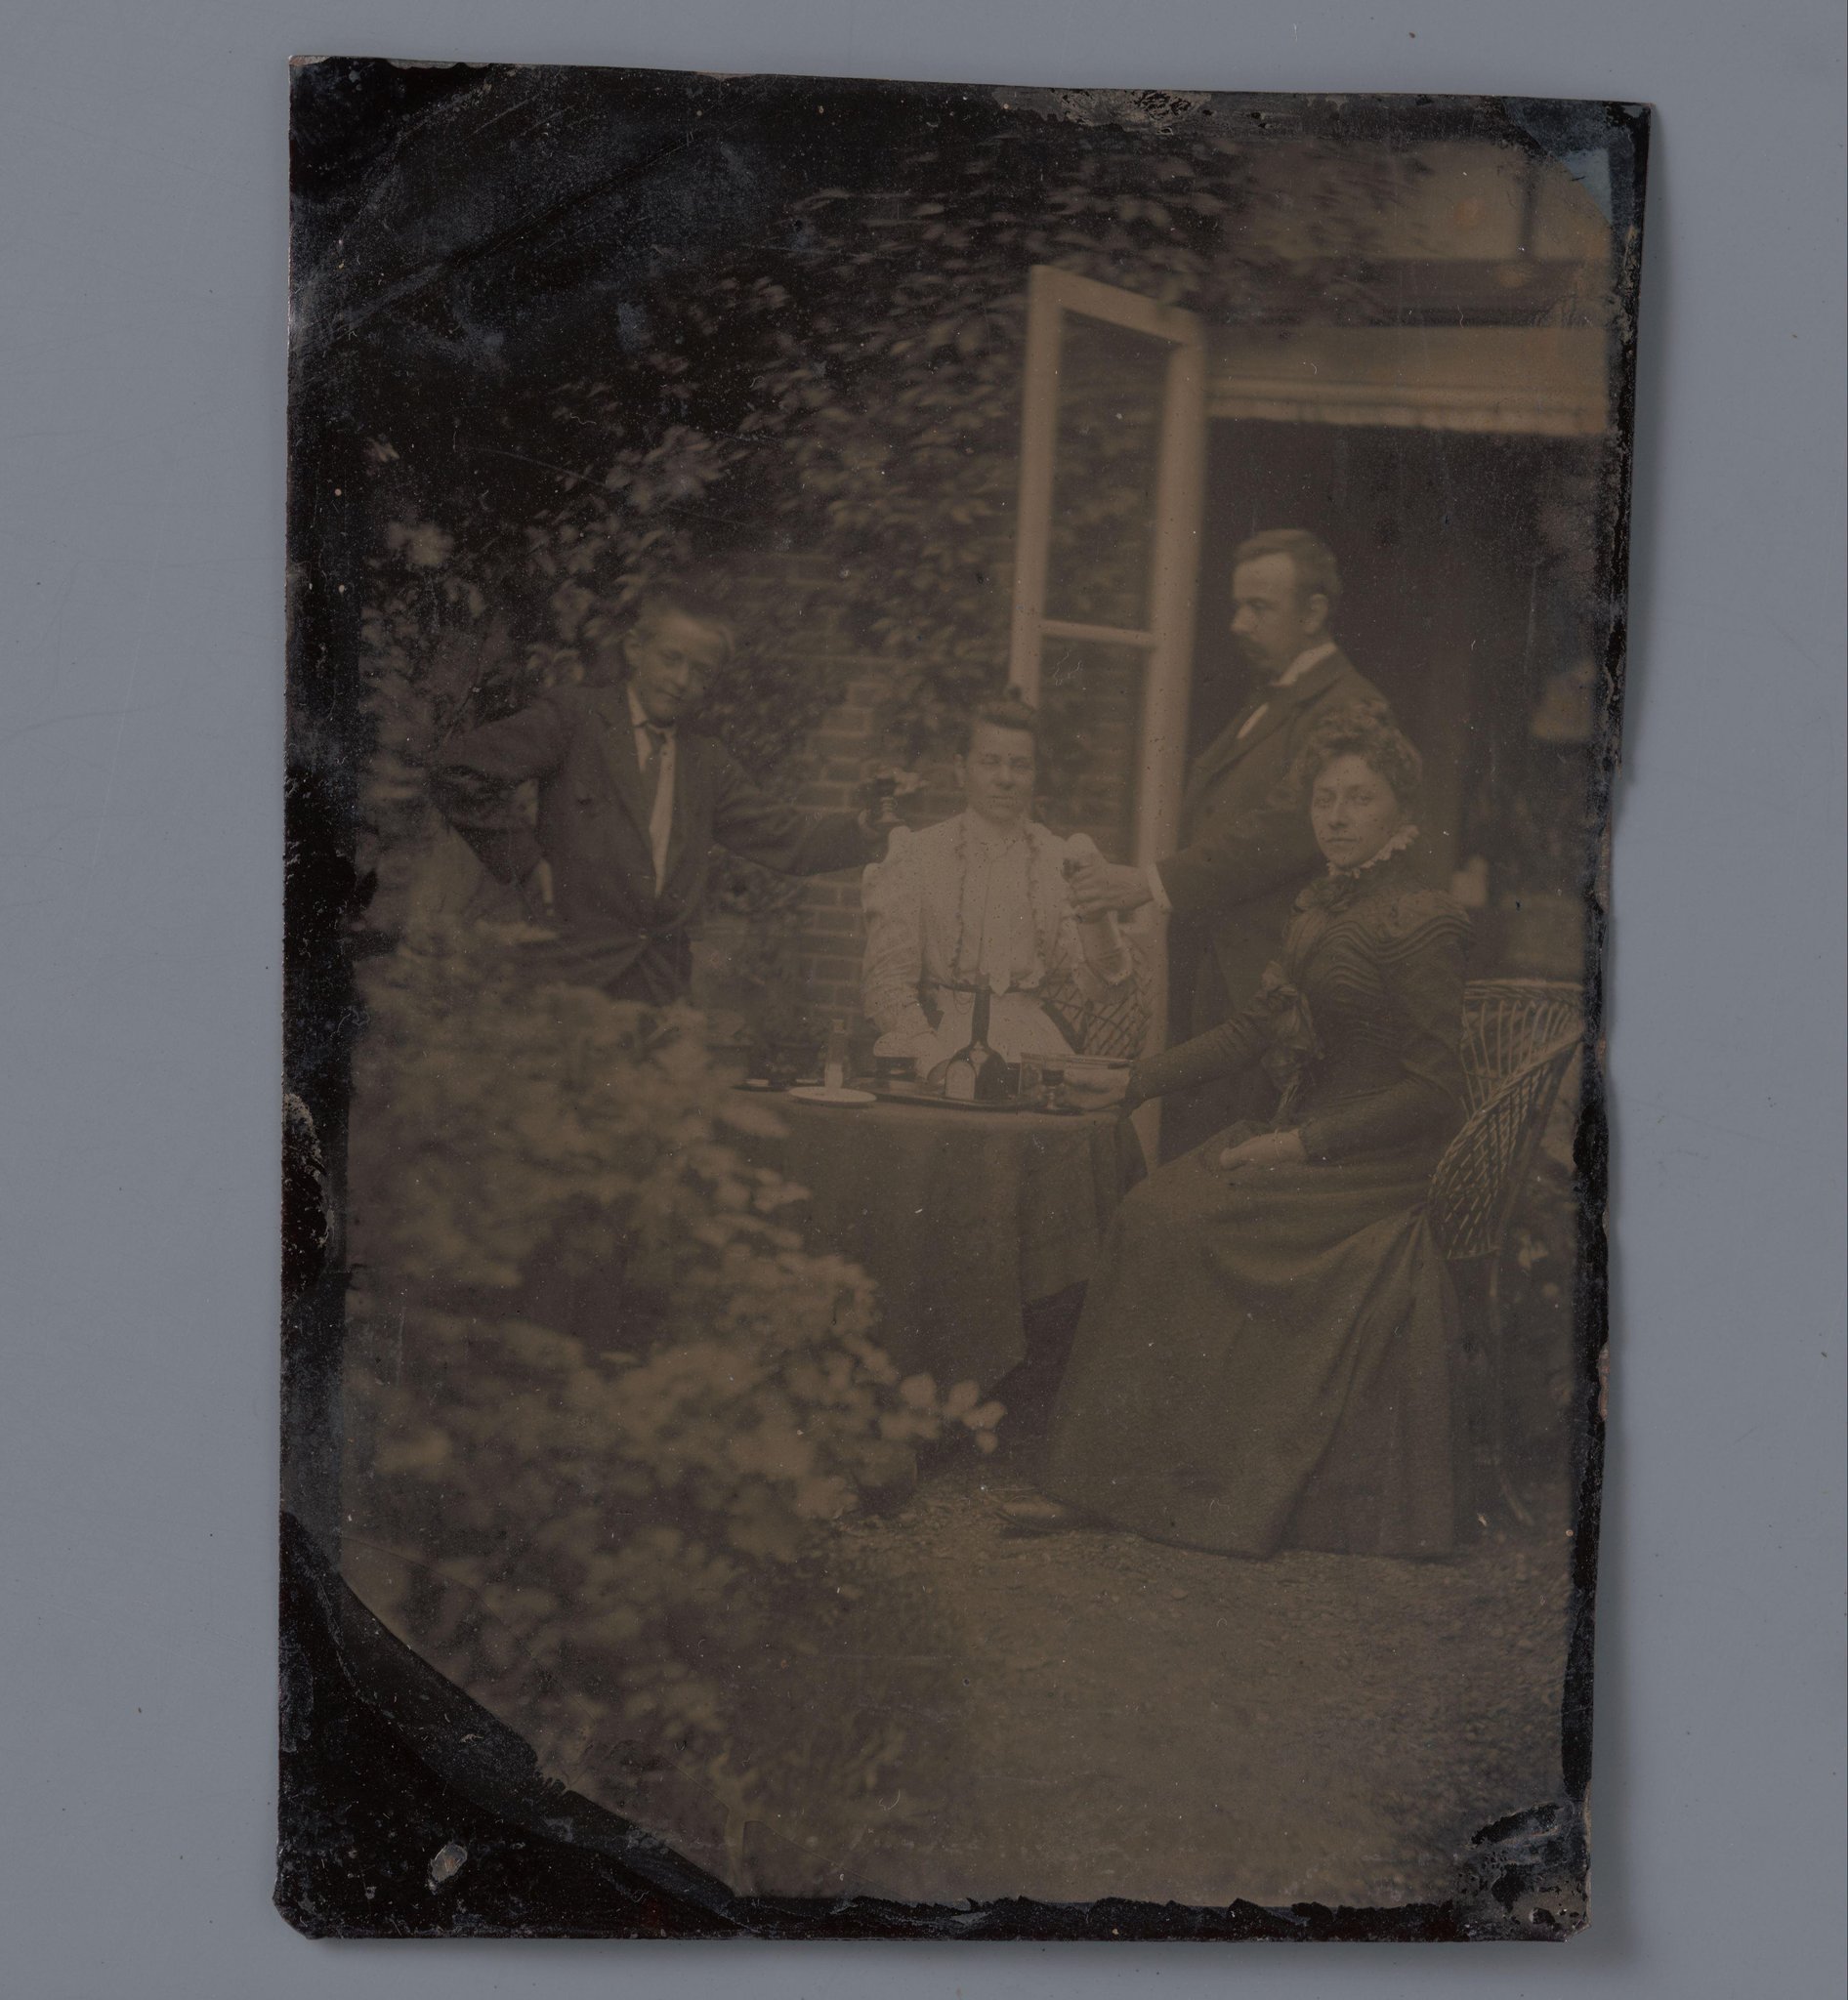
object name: photograph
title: Portret van de familie Van der Kop-Hoogendijk, rechtsvoor Wilhelmina Hoogendijk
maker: willem carel van der kop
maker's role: amateurfotograaf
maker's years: 1869-1924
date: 1890-1910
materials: iron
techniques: ferrotyping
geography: schoonhoven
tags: garden, staircase, anonymous historical persons portrayed in a group, in a group-portrait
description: Volgens verzamelaar L.J. Hartkamp is deze foto is aangetroffen in de foto's van de familie Van der Kop-Hoogendijk.